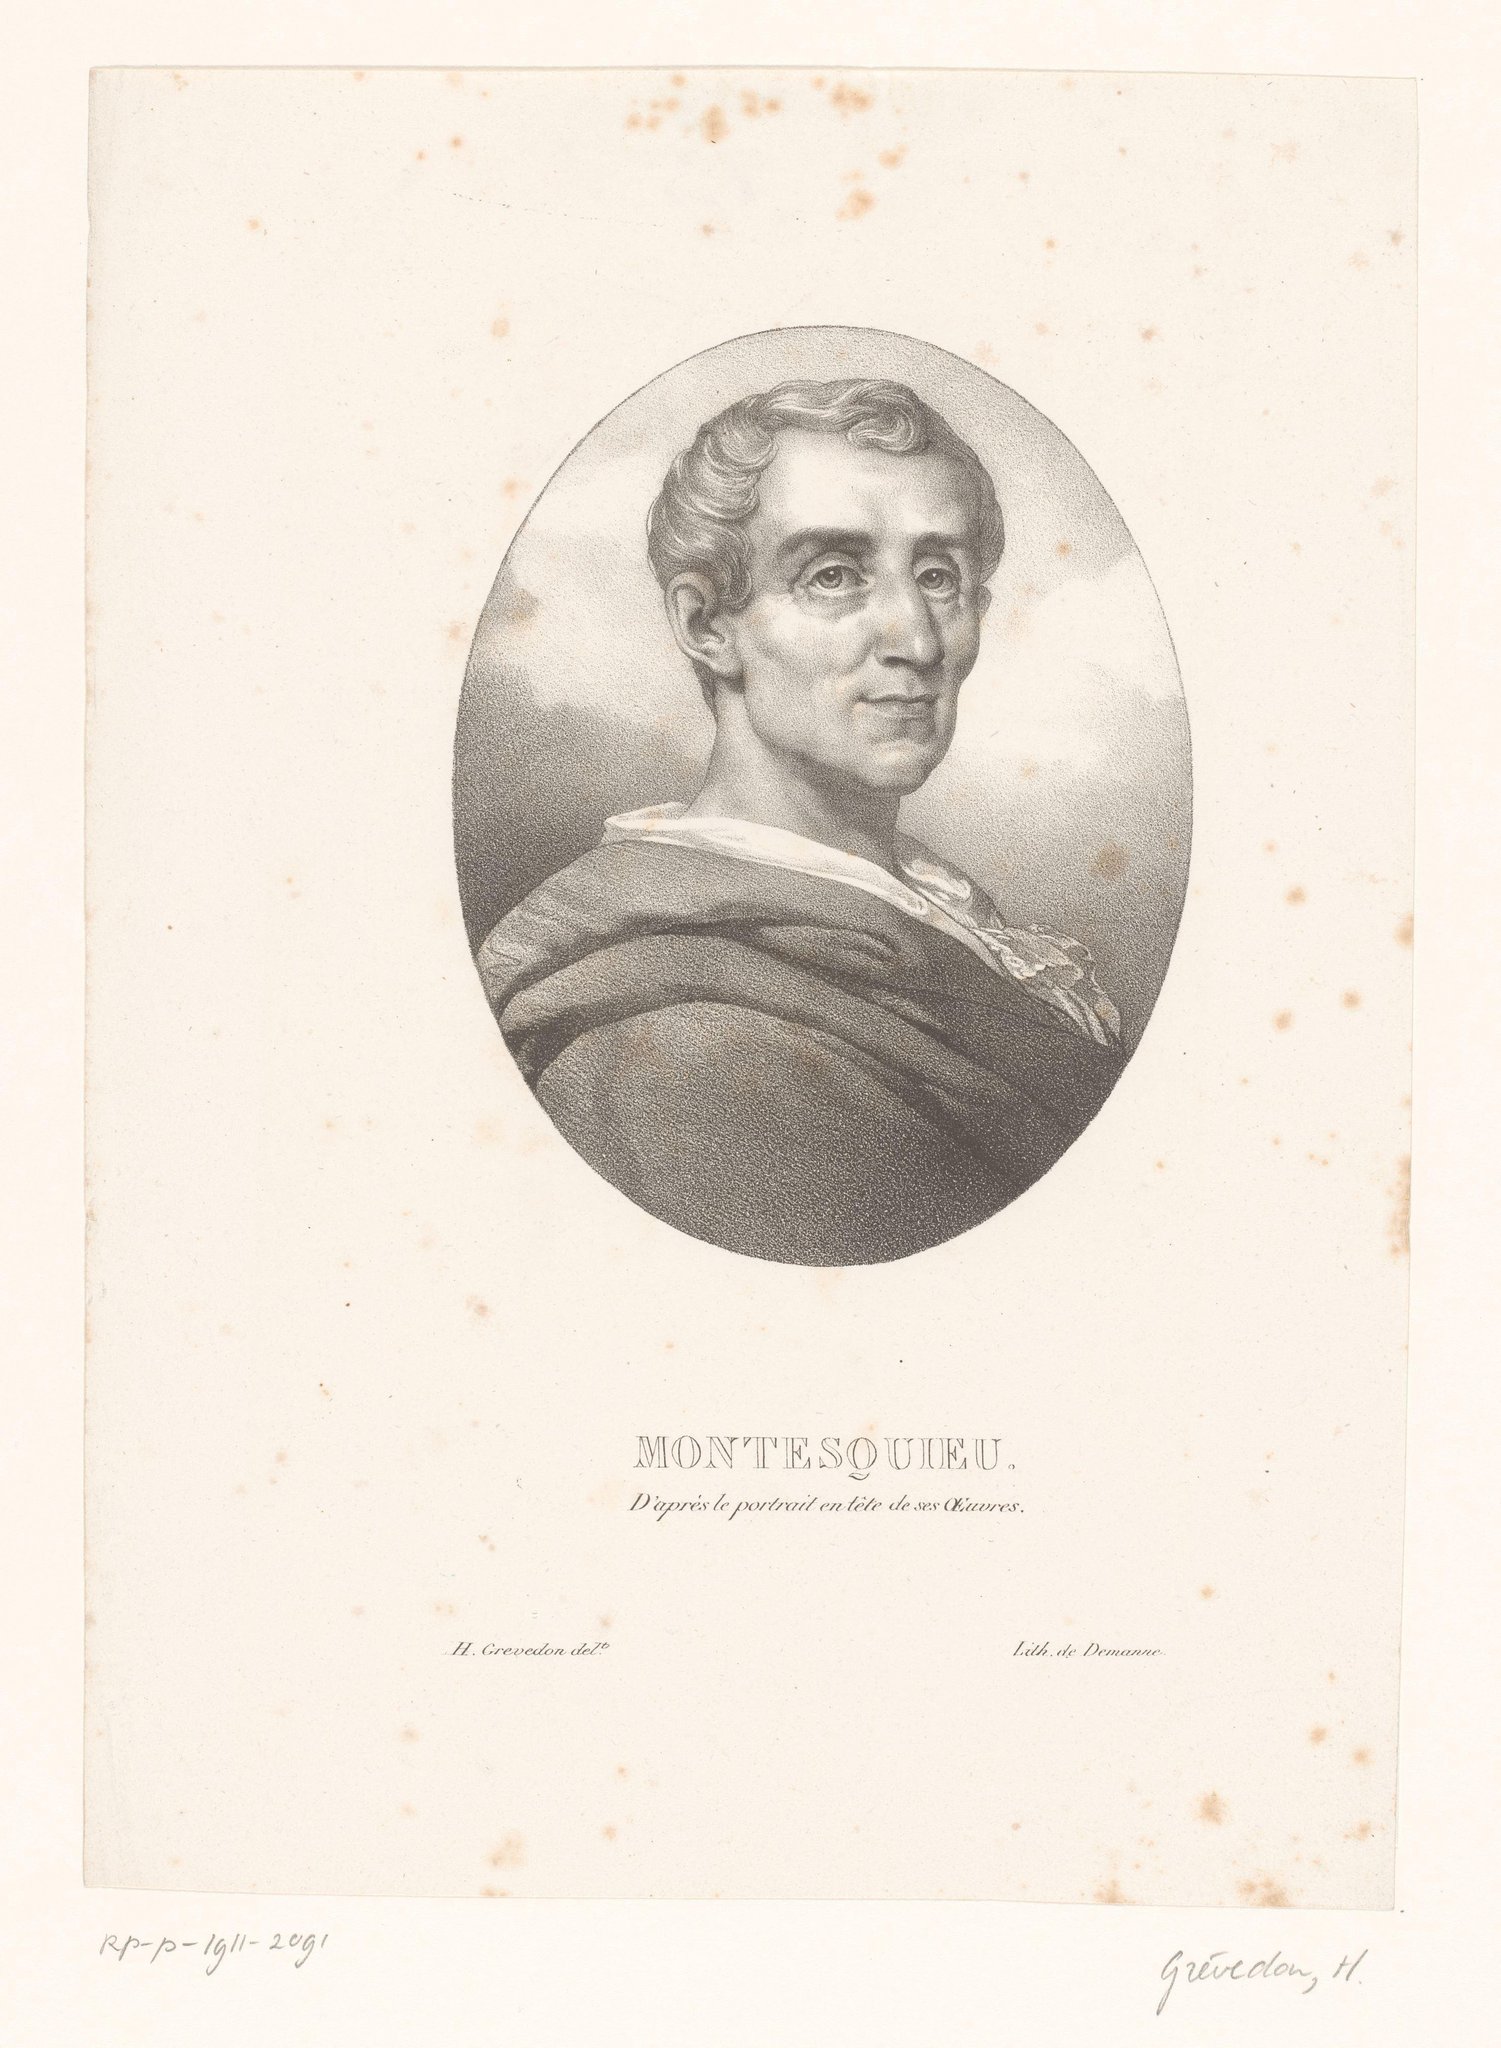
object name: print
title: Montesquieu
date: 1826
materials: paper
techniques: lithograph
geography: paris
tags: paris, historical persons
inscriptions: collector's mark: Lugt 2228a